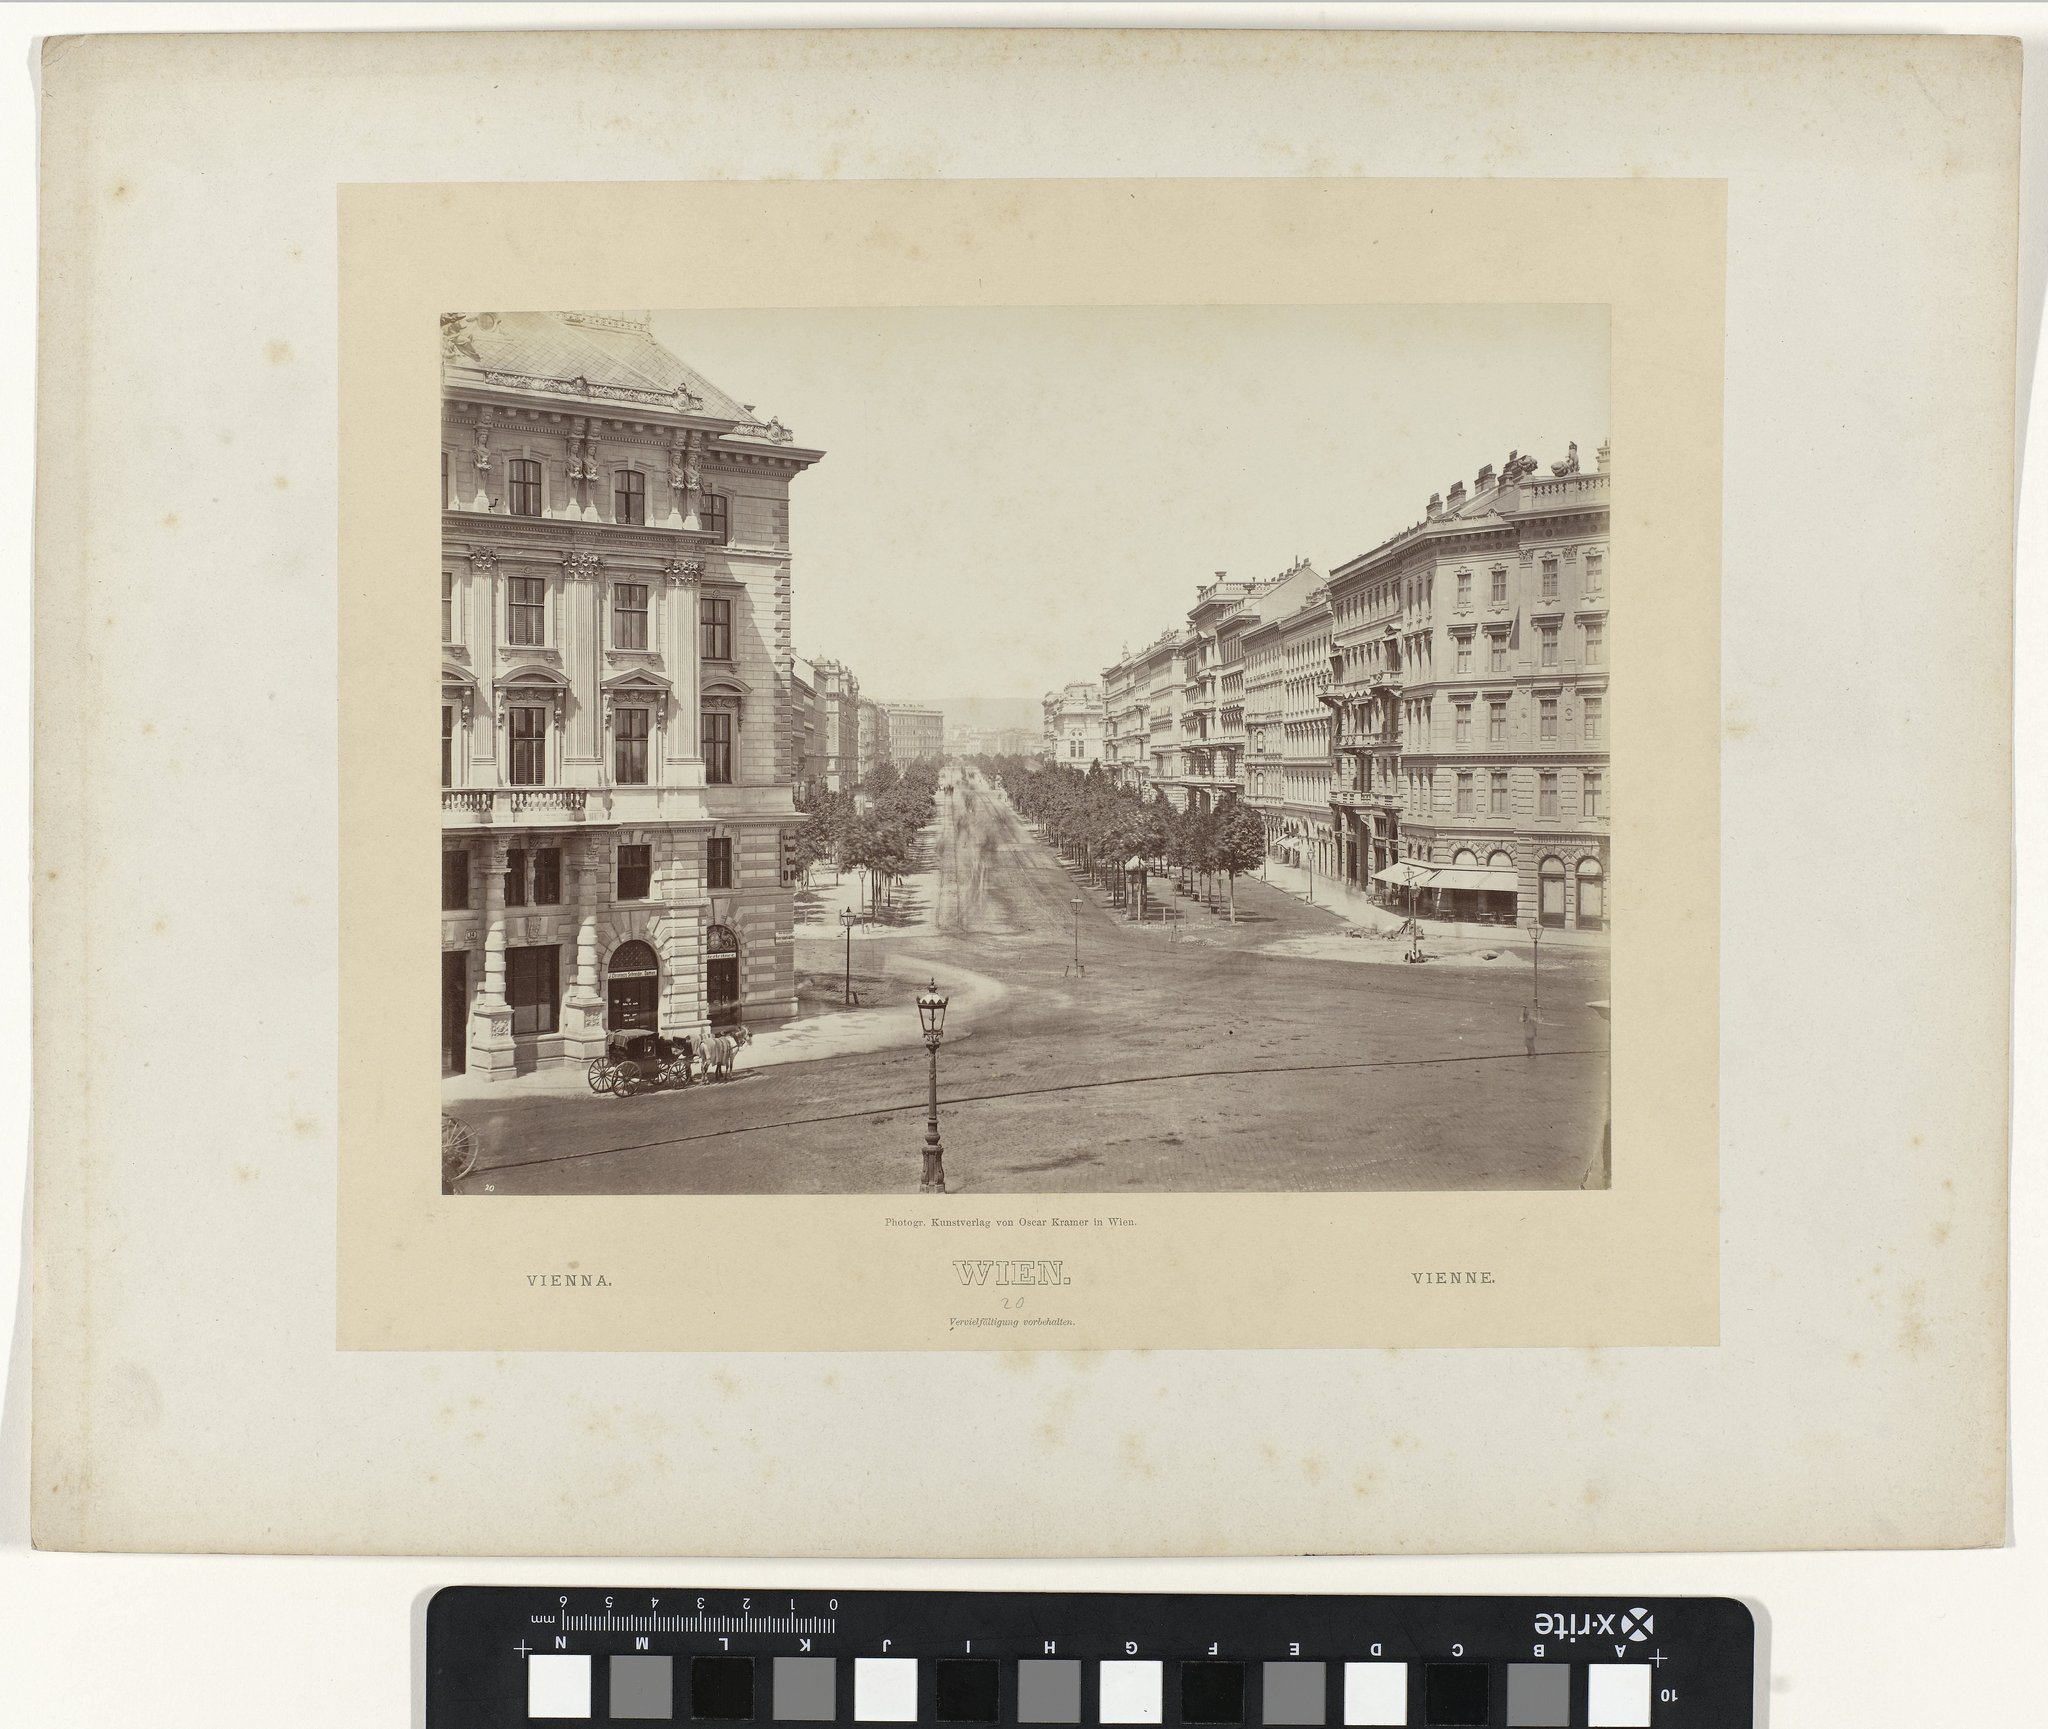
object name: photograph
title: Gezicht op een Allee te Wenen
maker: oscar krämer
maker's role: publisher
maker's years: 1835-1892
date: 1870-1880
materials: cardboard, photographic support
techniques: albumen print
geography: vienna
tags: city-view in general; 'veduta', vienna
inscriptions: title, number: ‘20’, signature